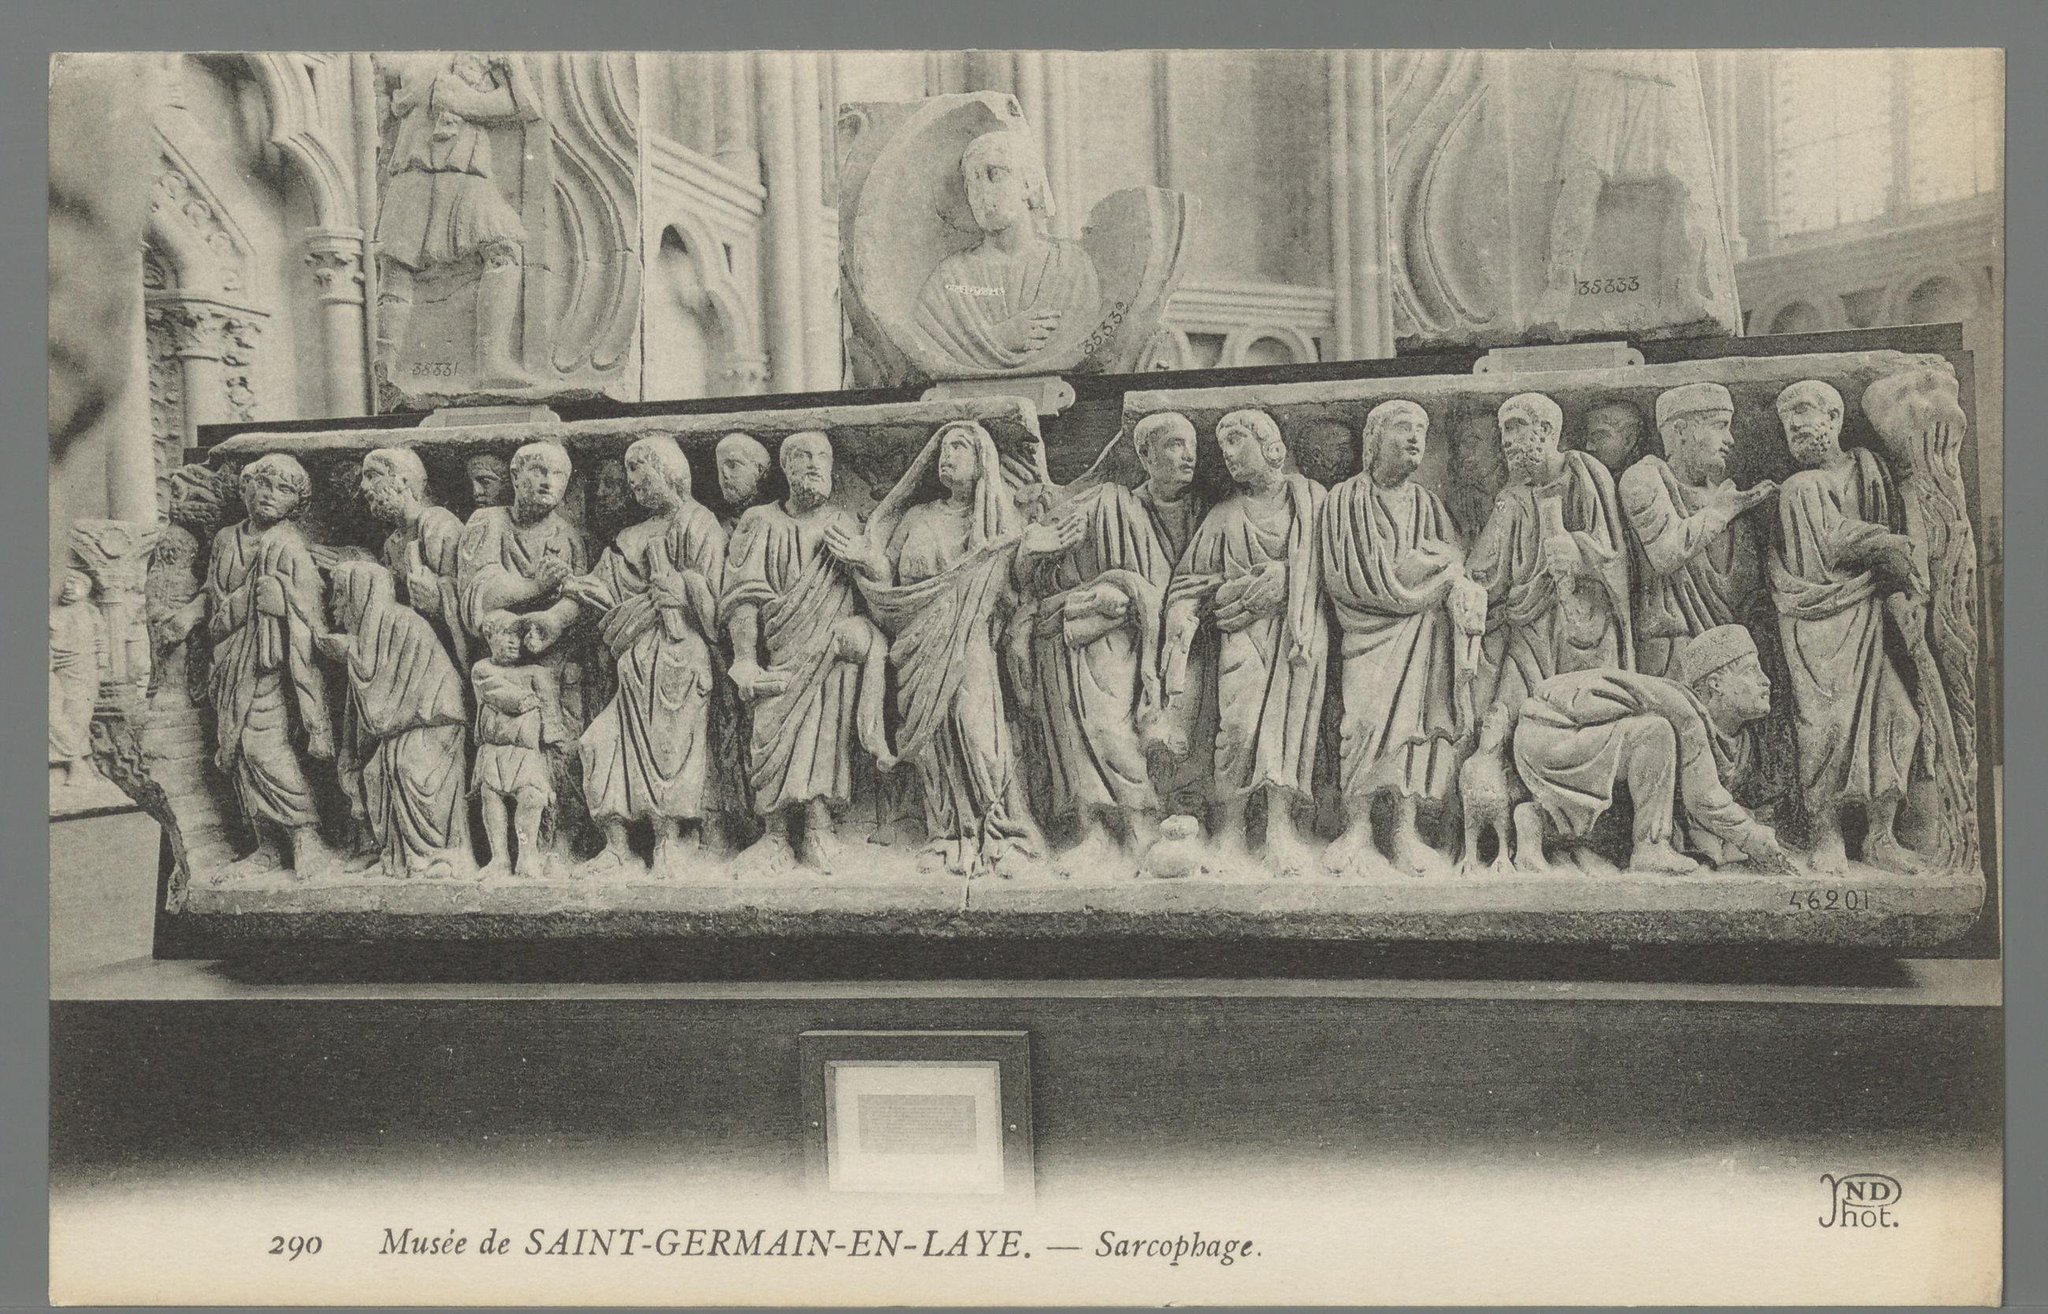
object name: photomechanical print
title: Musée de Saint-Germain-en-Laye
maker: Anonymous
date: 1903-1918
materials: cardboard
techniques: photograph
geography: saint-germain-en-laye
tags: sarcophagus, permanent exhibition, museum